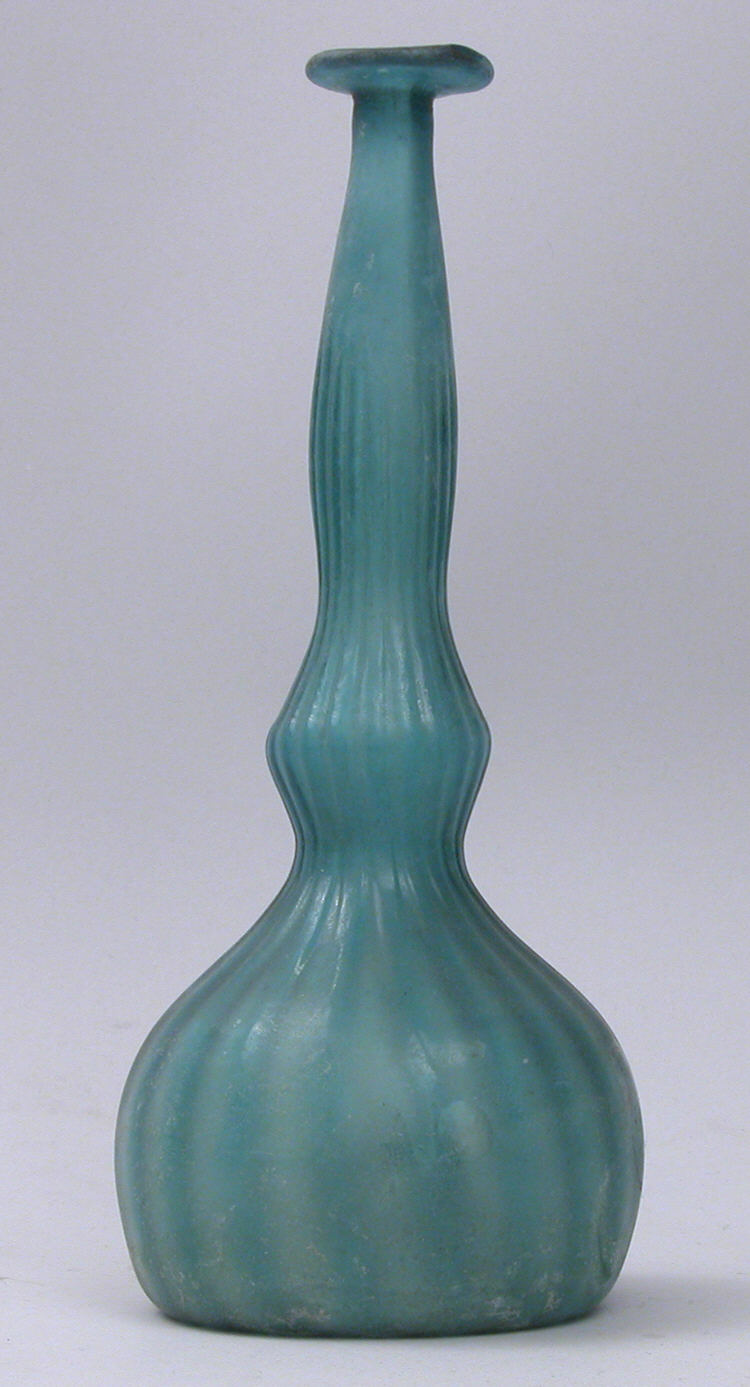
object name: bottle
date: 1701-1900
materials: glass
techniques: glassblowing, tooling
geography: iran